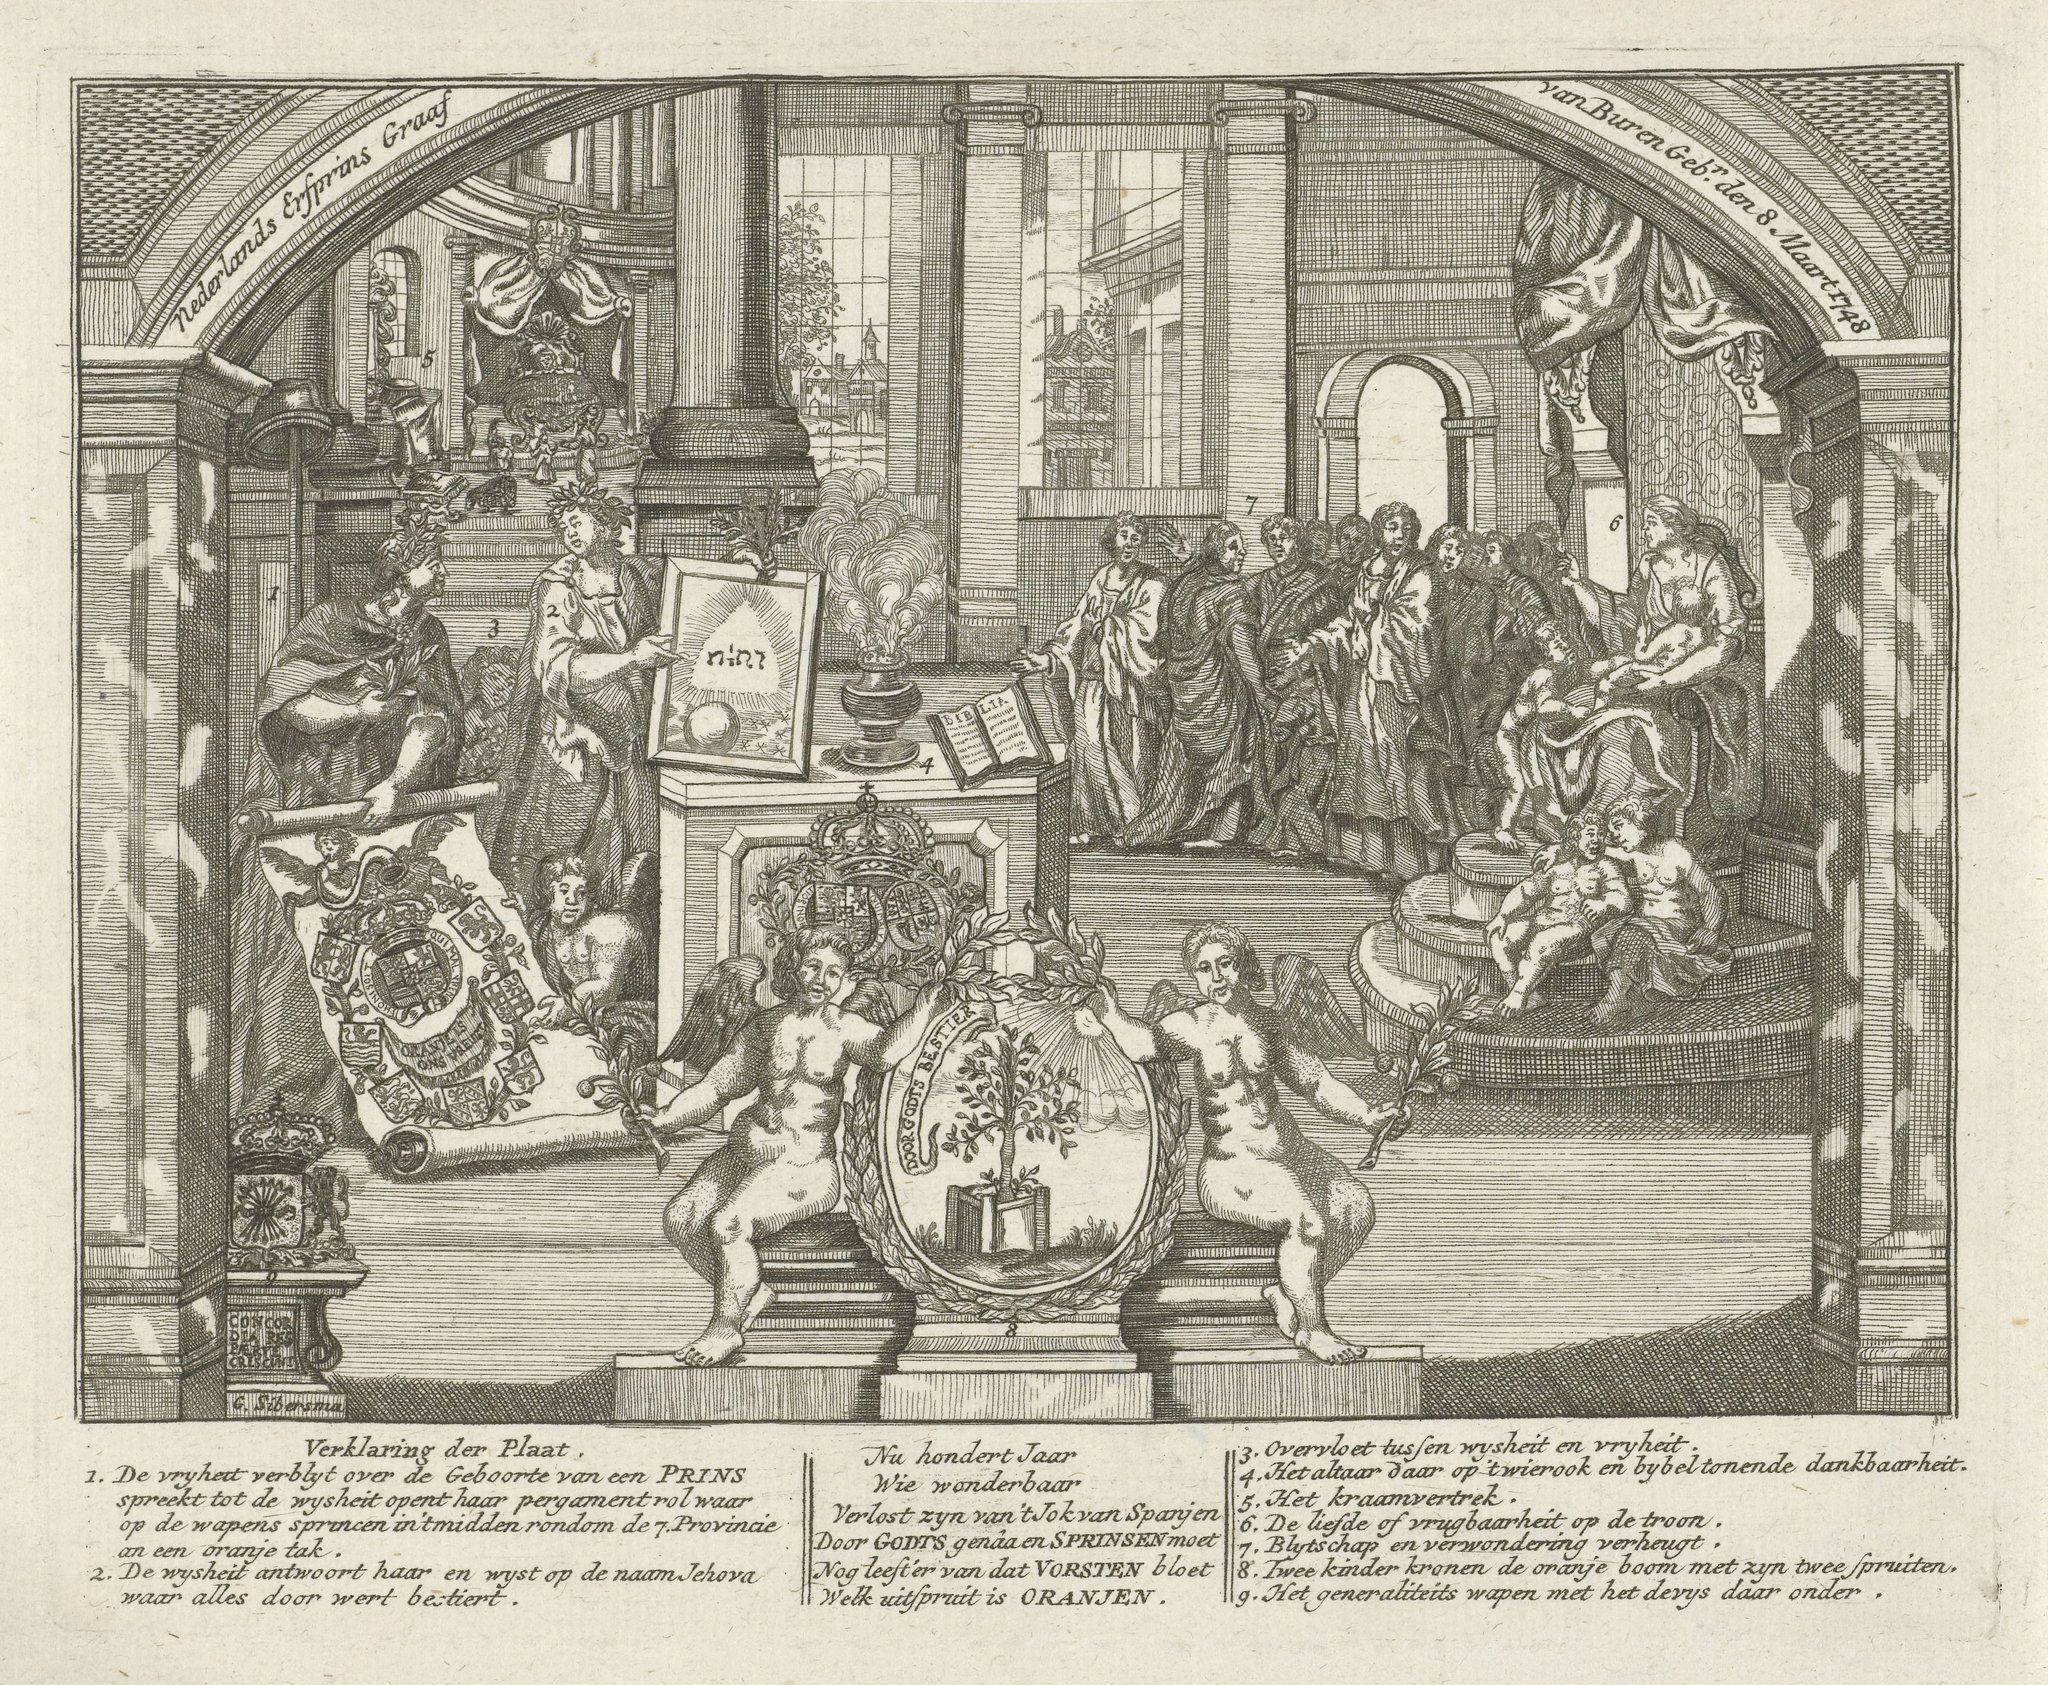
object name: print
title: Allegorie op de geboorte van de prins van Oranje, 1748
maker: gerrit sibersma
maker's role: print maker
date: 1748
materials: paper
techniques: engraving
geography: northern netherlands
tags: the hague, william v (prince of orange), charity, 'caritas'; 'carità' (ripa) ~ one of the three theological virtues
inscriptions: collector's mark: Lugt 2228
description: Allegorie op de geboorte van Willem V, de graaf van Buren, prins van Oranje, 8 maart 1748. Interieur met links de Vrijheid en de Wijsheid, rechts de Liefde op de troon, centraal twee putti met een embleem met de Oranjeboom. In het onderschrift in de plaat de verklaring van de cijfers 1-9.